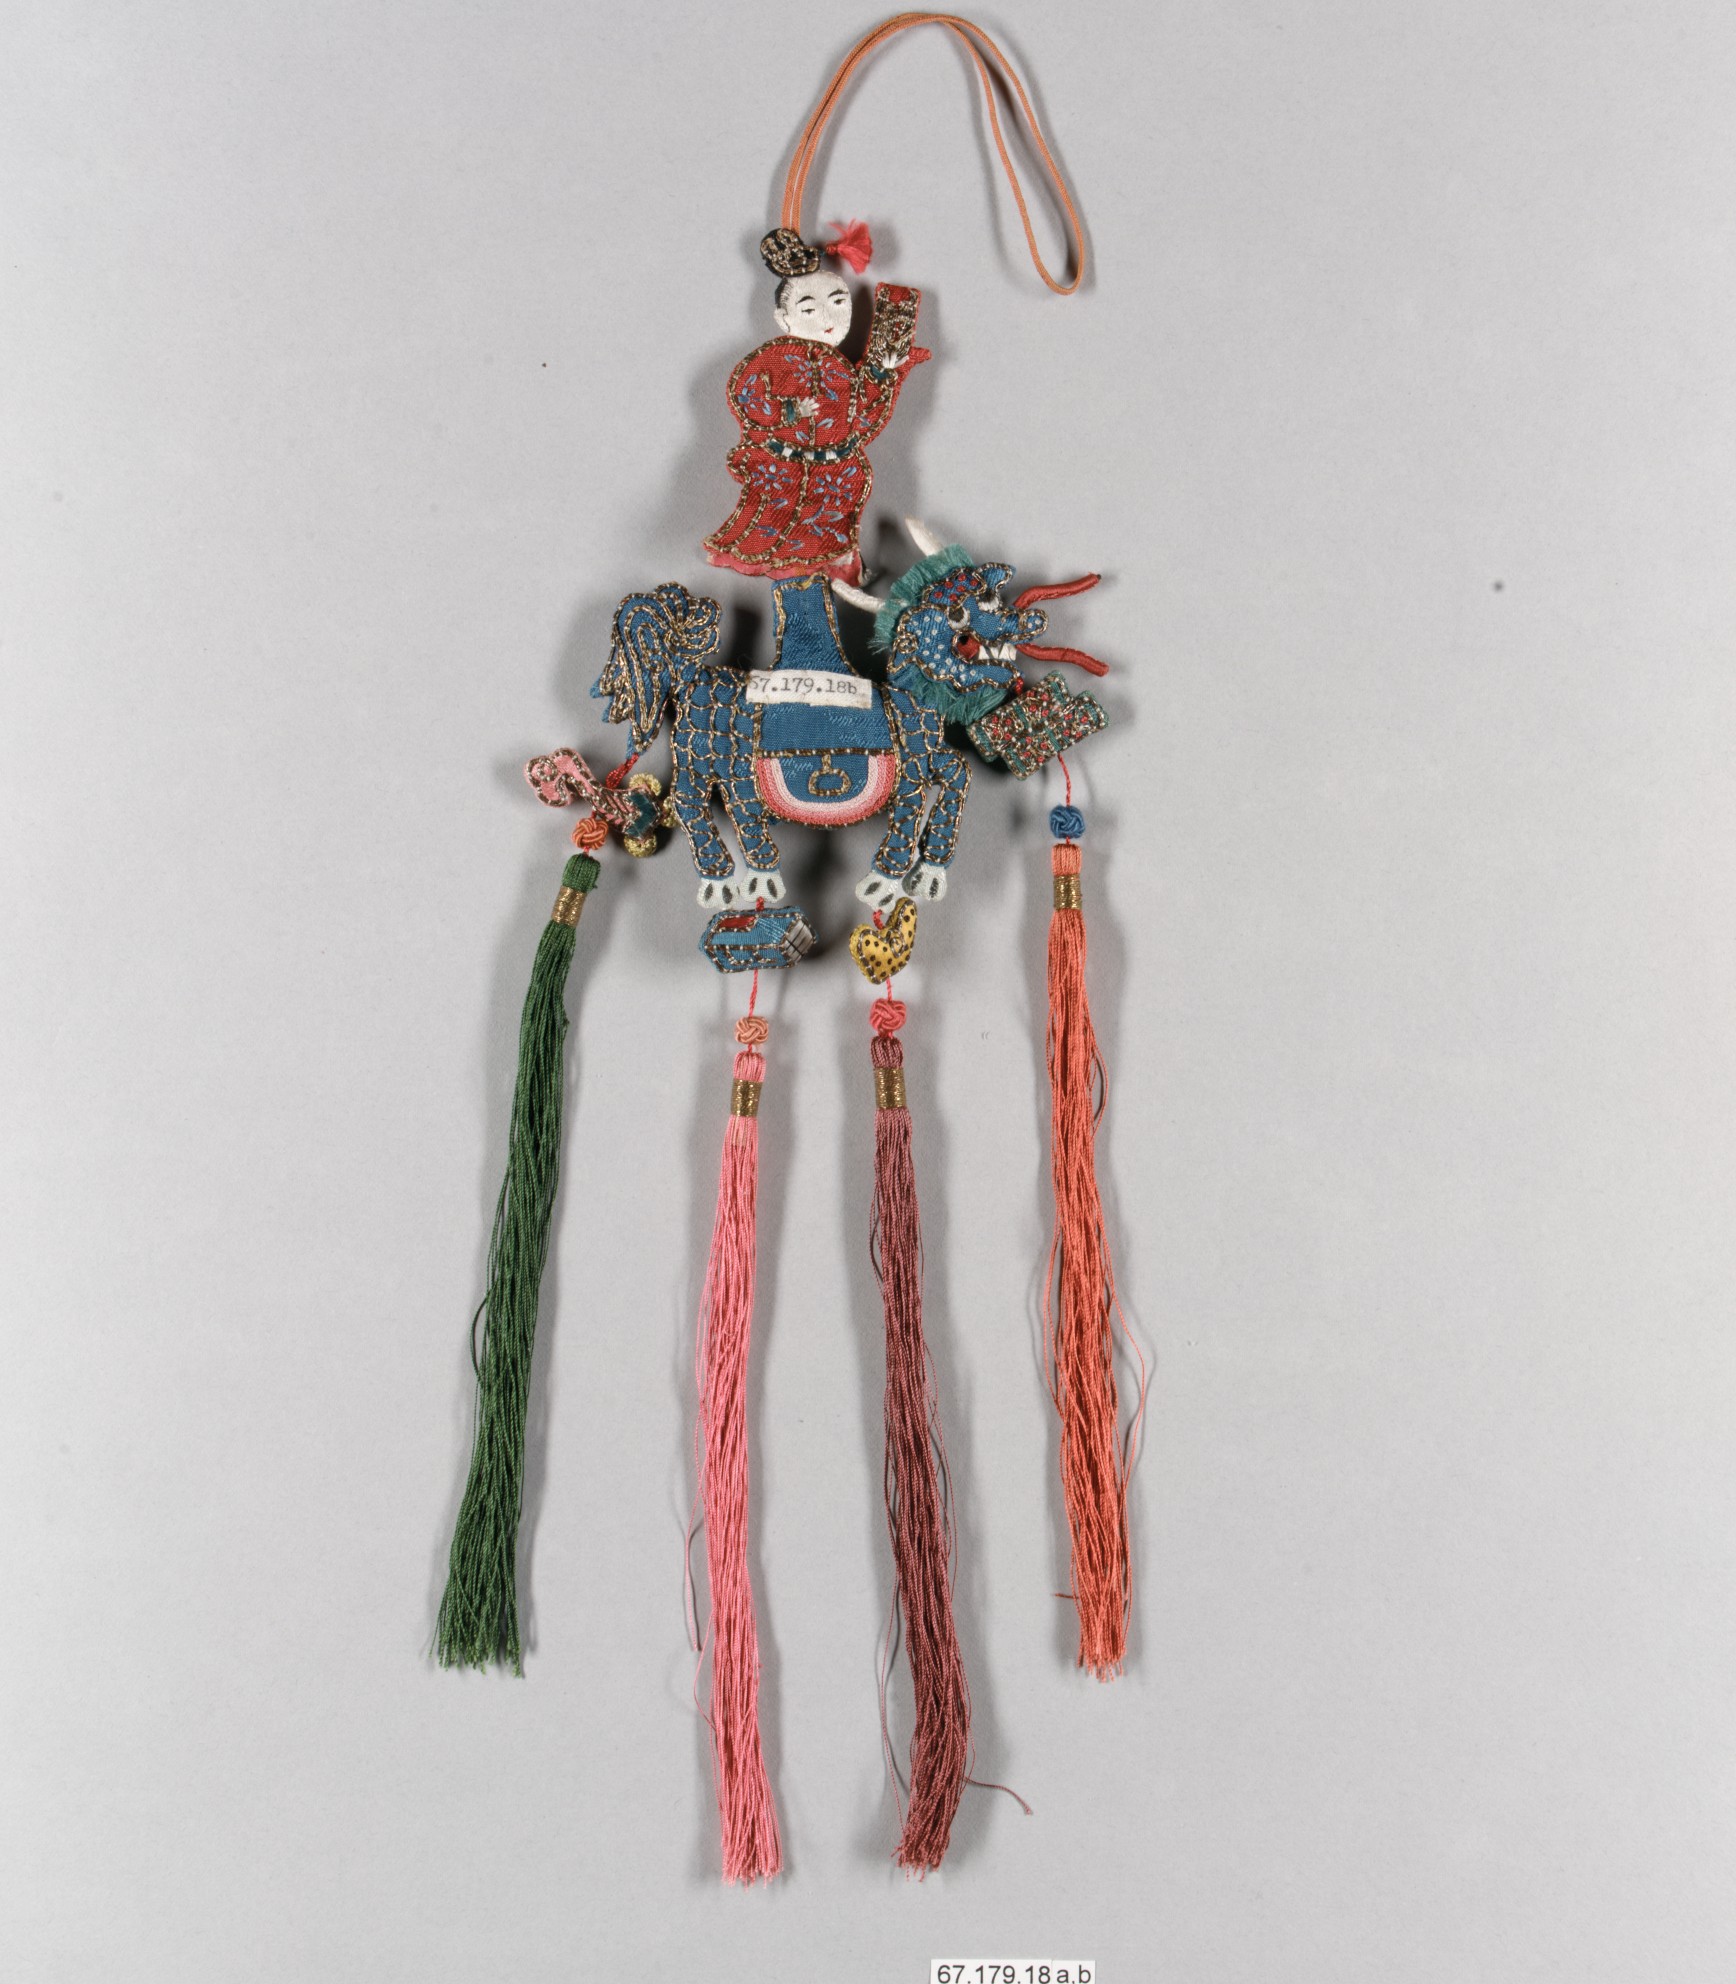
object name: toy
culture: chinese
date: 1801-1900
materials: metal thread, silk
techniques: embroidery, weave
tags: men,mythical creatures,toys